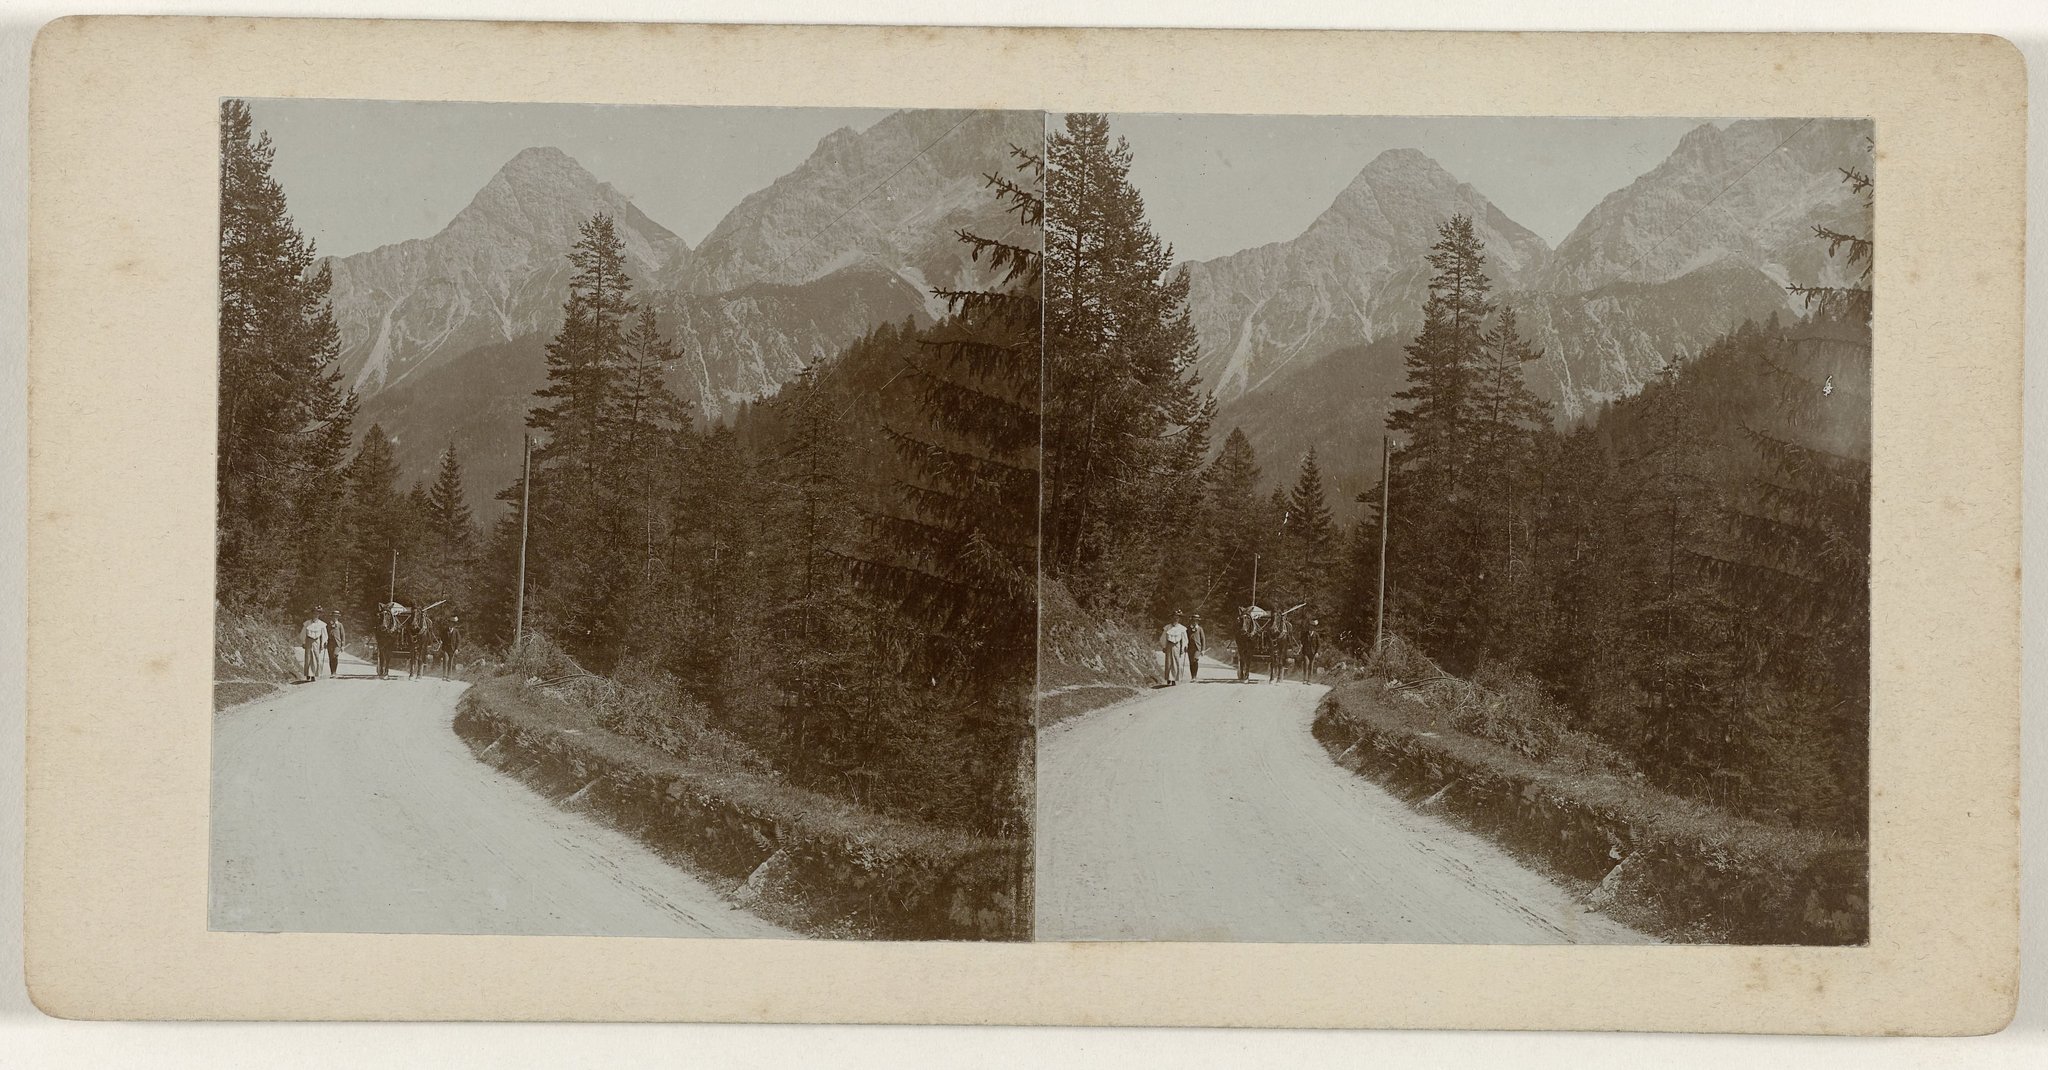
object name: stereograph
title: Garmisch - Sulden 1906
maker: geldolph adriaan kessler (dolph)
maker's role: fotograaf, industrieel, voetballer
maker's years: 1884-1945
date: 1906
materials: paper, photographic support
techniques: collodion silver print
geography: gelderland